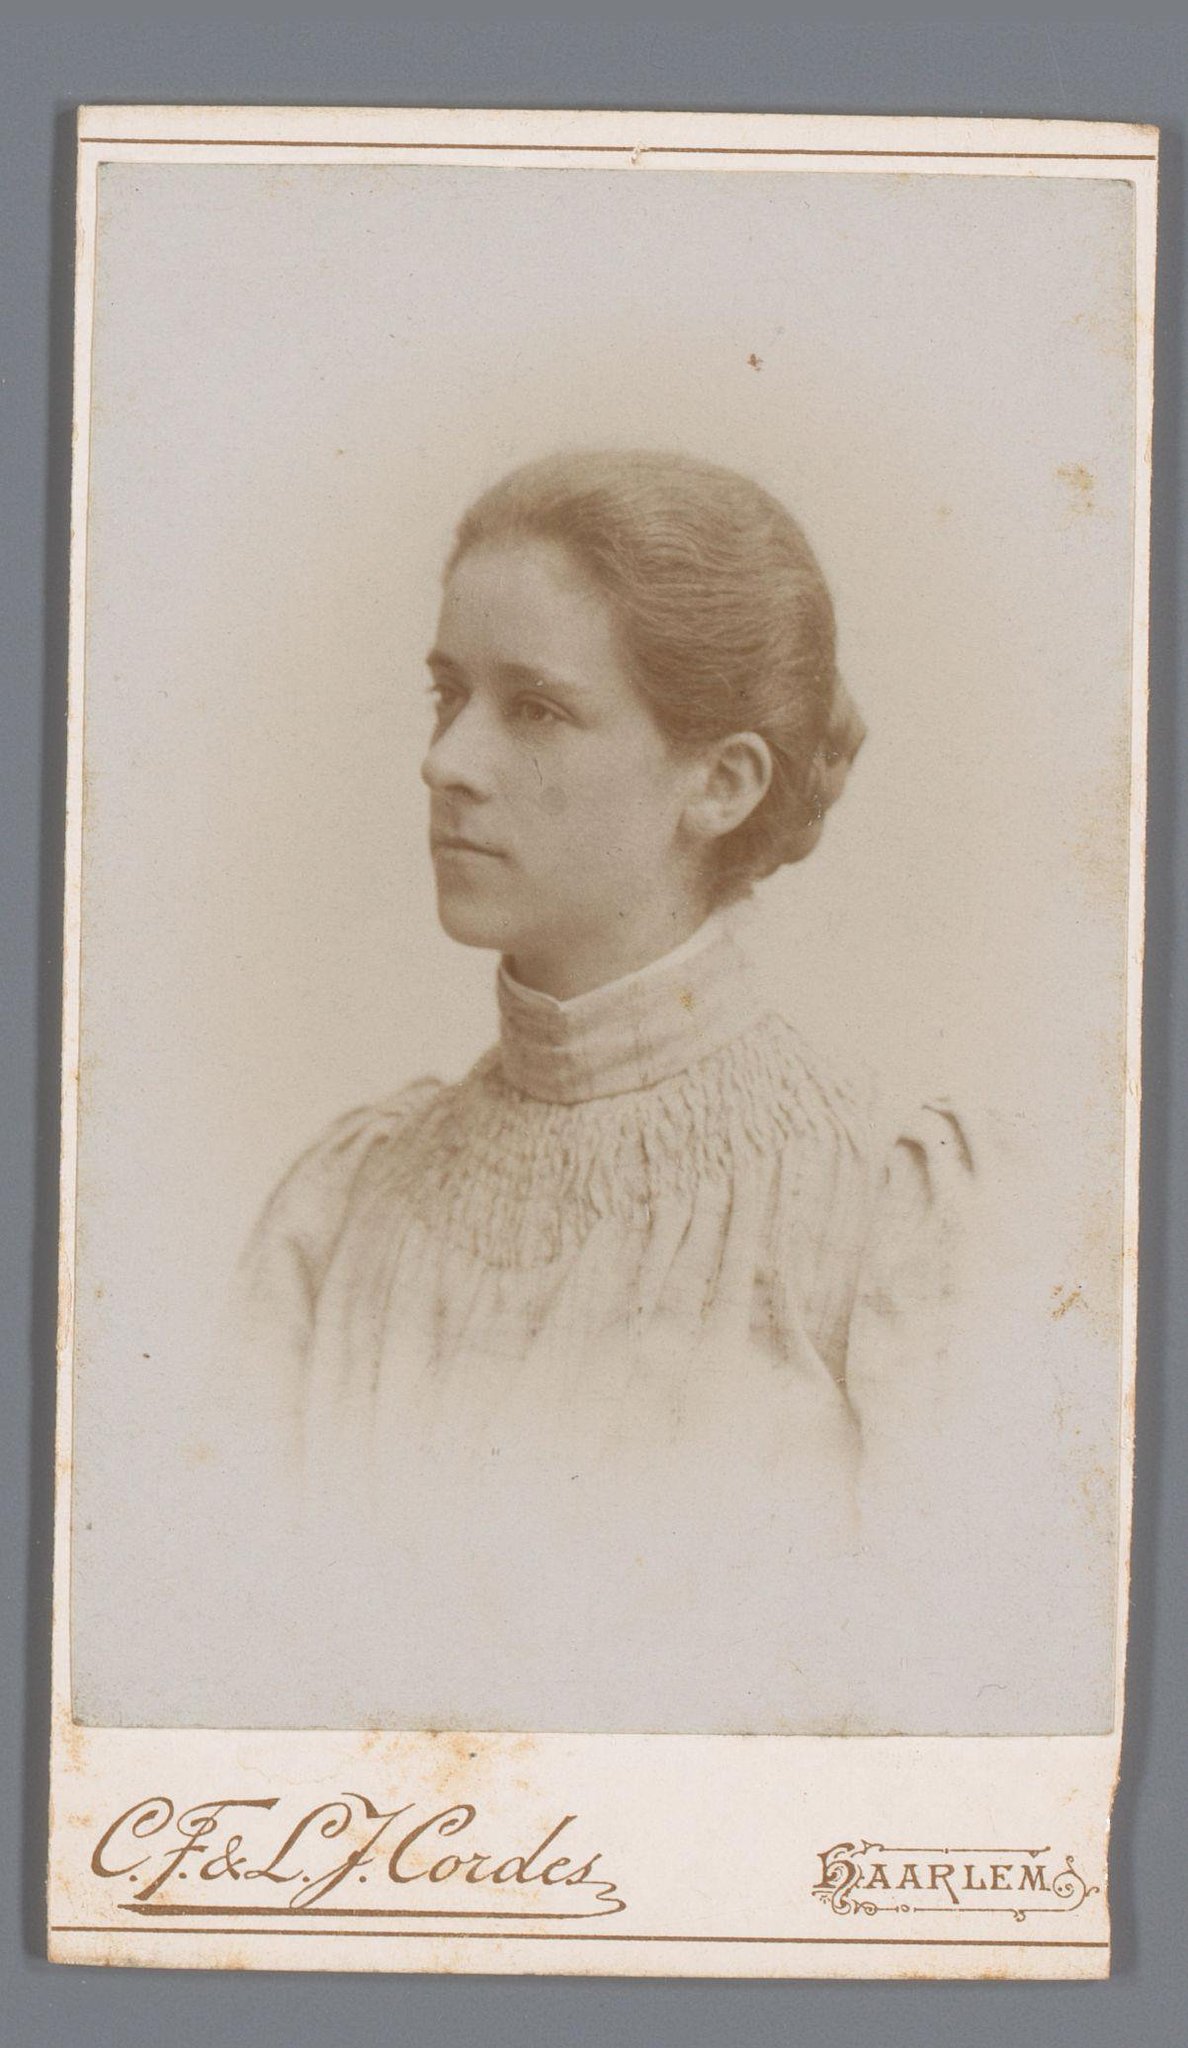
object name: carte de visite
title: Portret van Charlotte Hooykaas van der Linden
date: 1881-1901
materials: cardboard, photographic support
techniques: collodion silver print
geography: haarlem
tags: historical persons, haarlem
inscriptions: annotation: ‘Charlotte Hoogkaas v.d. Linden’, workshop stamp: ‘C.J. & L.J. Cordes/ Haarlem, Groote Houtstraat 84/ 's Bosch a/d. Parade’